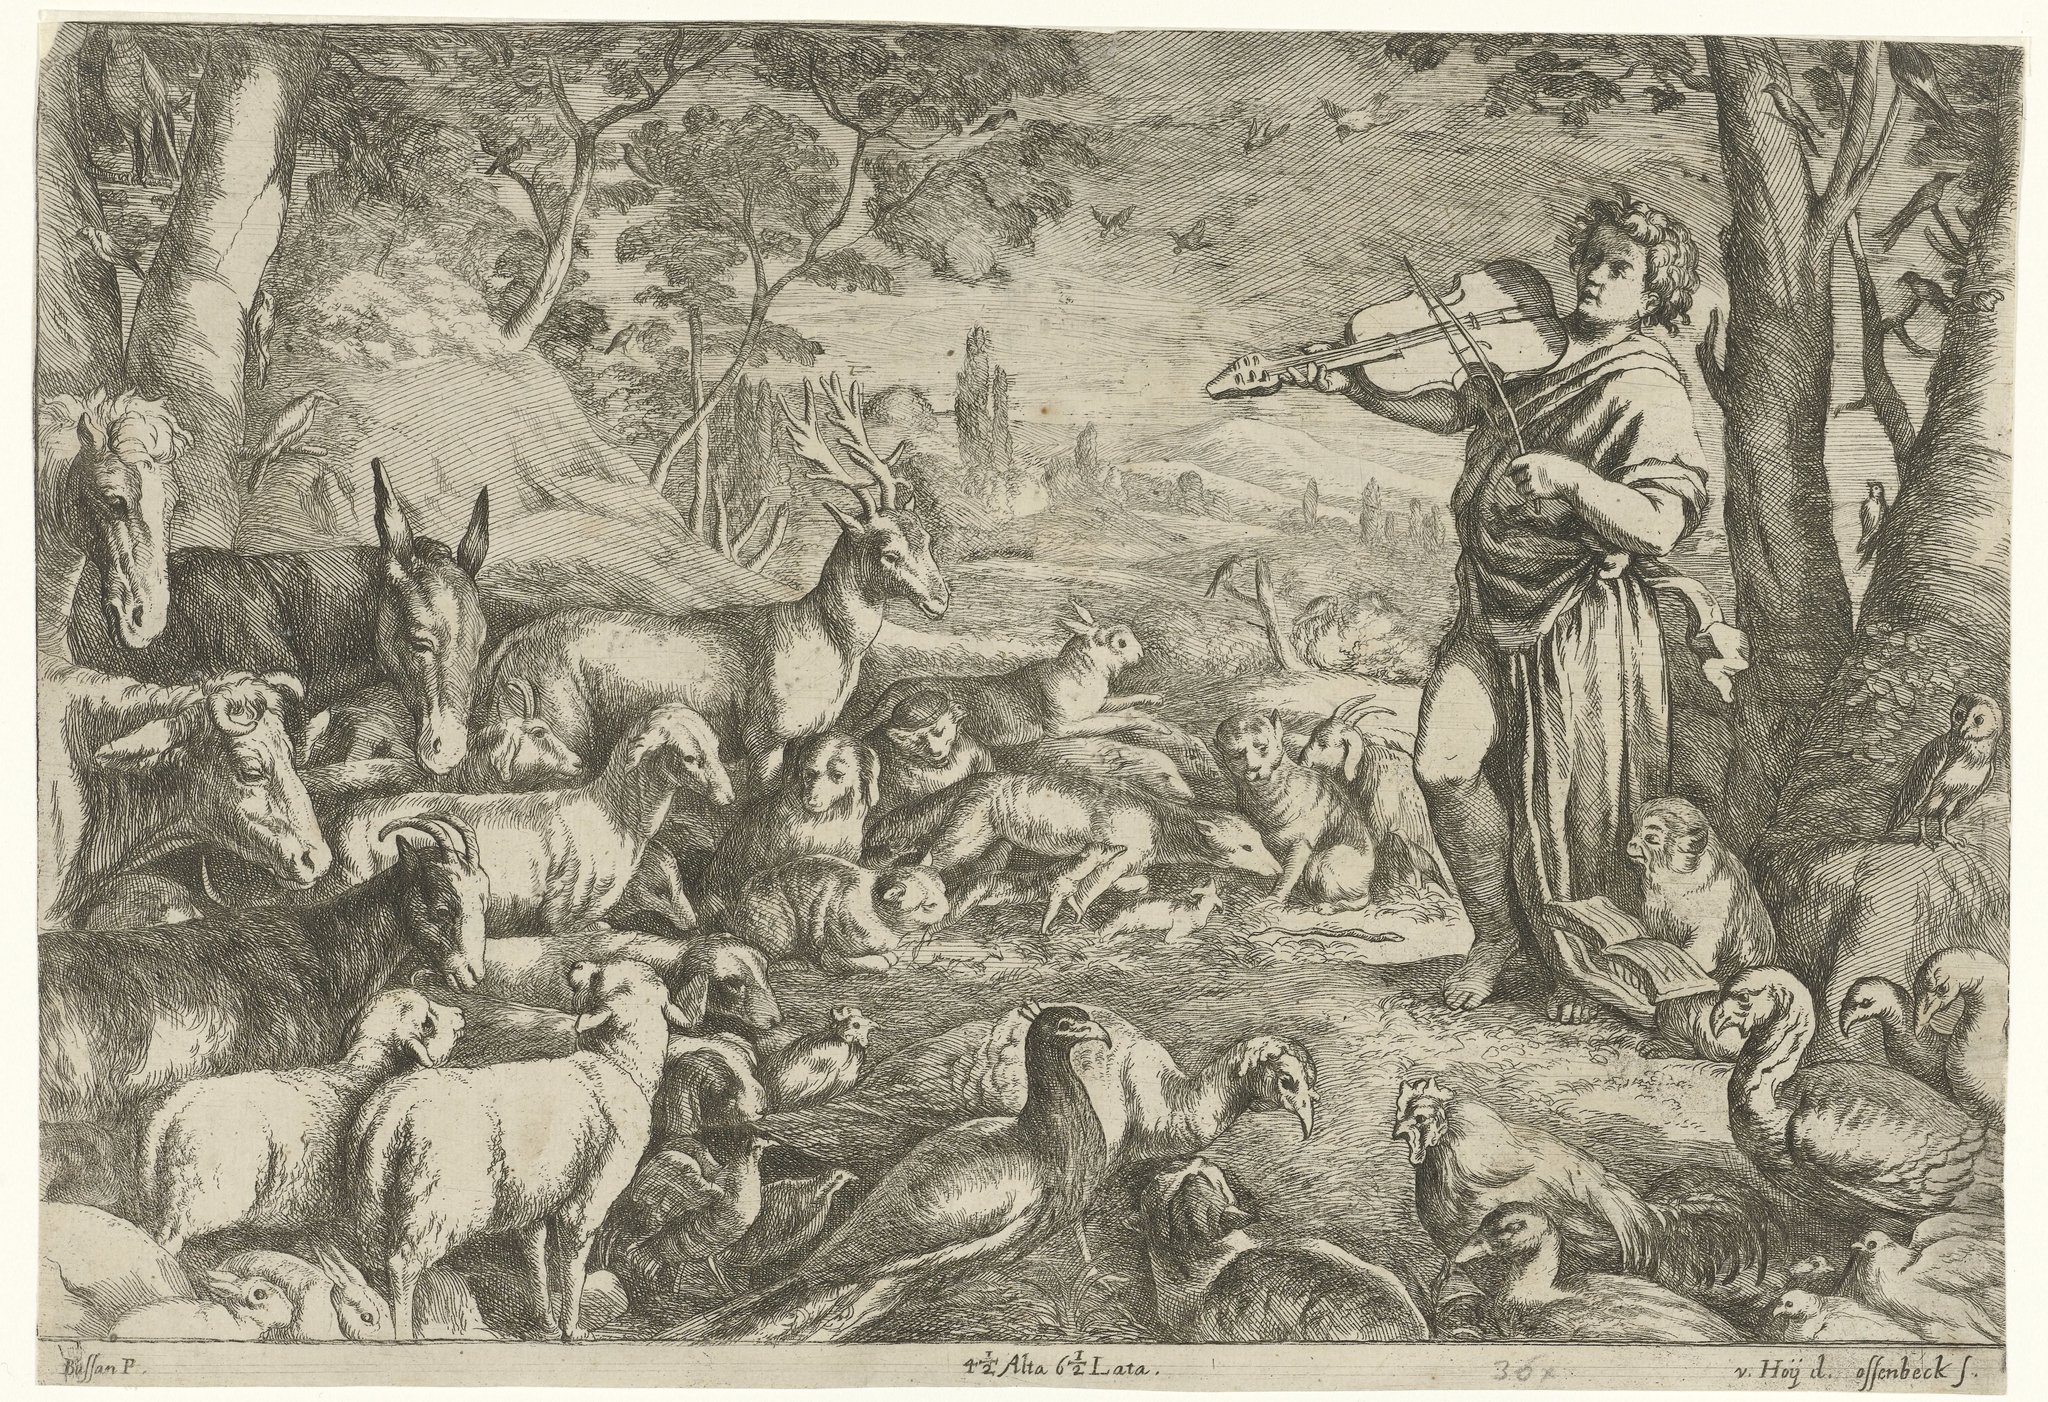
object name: print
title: Orpheus temt de dieren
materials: paper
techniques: etching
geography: brussels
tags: orpheus playing the lyre: trees and rocks move, beasts and birds are enchanted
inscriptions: collector's mark: Lugt 2228, collector's mark: Lugt 2610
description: Prent gemaakt als reproductie van een schilderij uit de collectie van aartshertog Leopold Willem van Oostenrijk te Brussel: David Teniers, Theatrum pictorum. Verschillende editites. Eerste editie uit 1660.